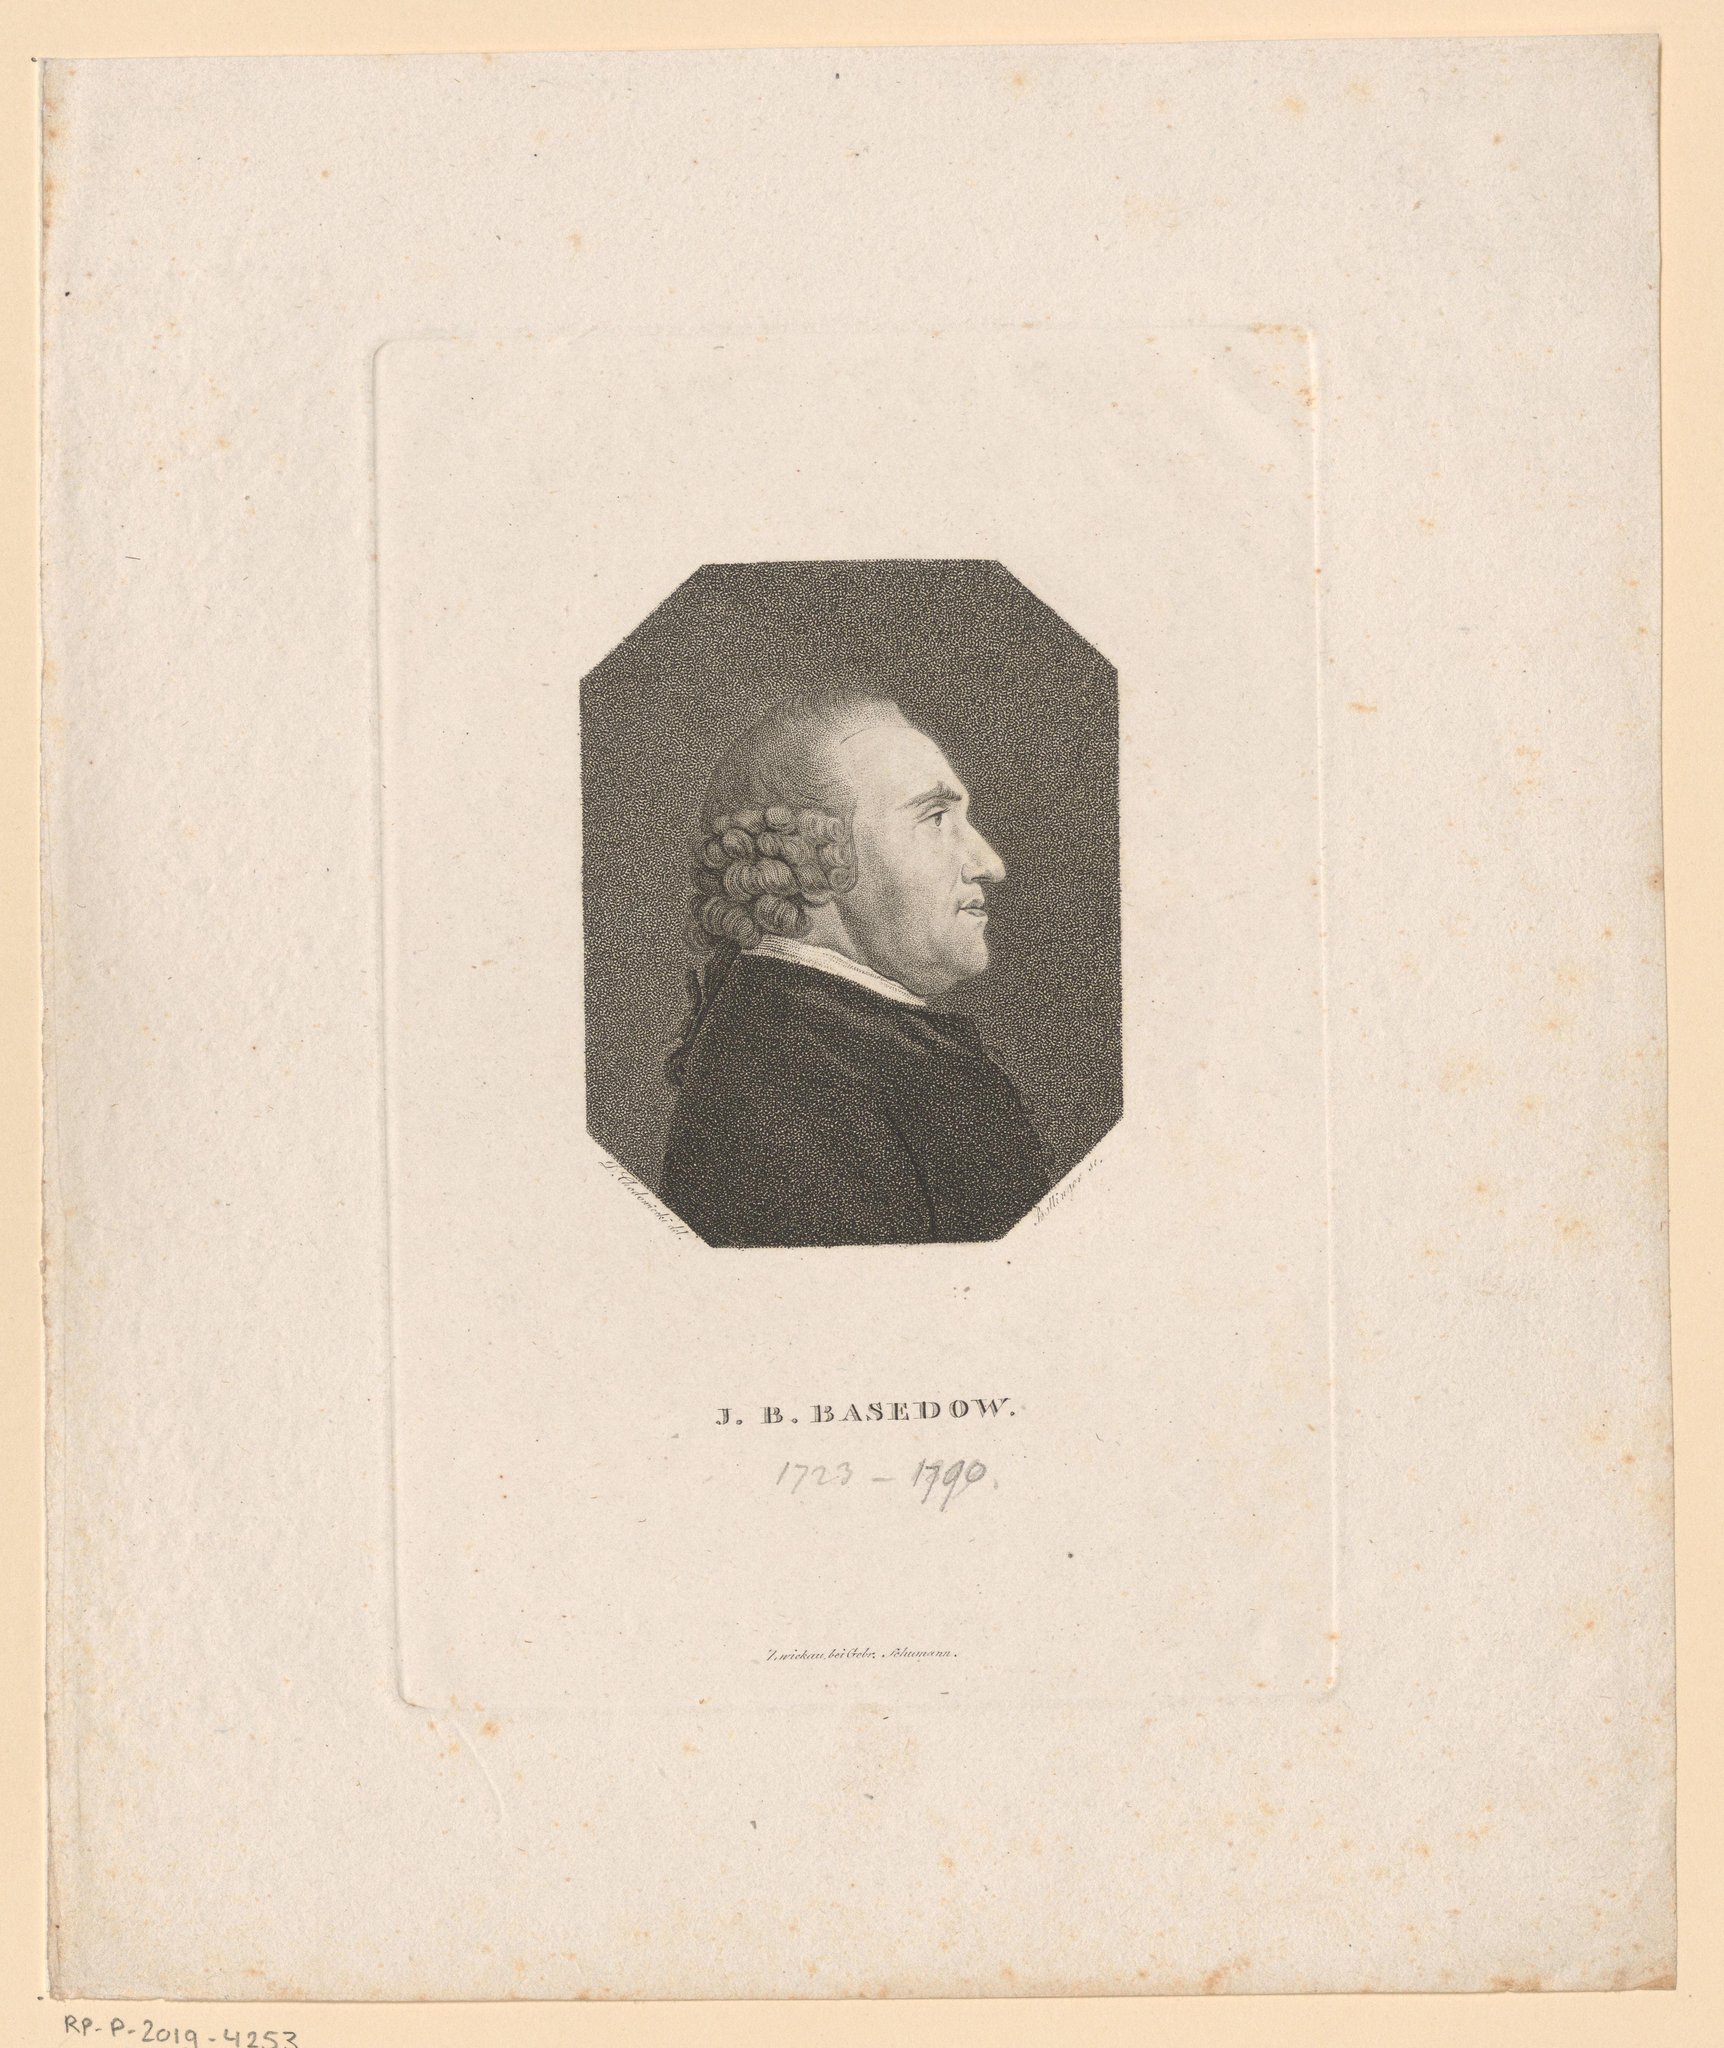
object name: print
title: Portretten van beroemde mensen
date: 1818-1832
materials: paper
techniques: etching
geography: zwickau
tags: johann bernhard basedow, historical persons, portrait of a writer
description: Prent uit: Bildnisse der berühmtesten Menschen aller Völker und Zeiten. Zwickau: gebroeders Schumann, 1818-1832.